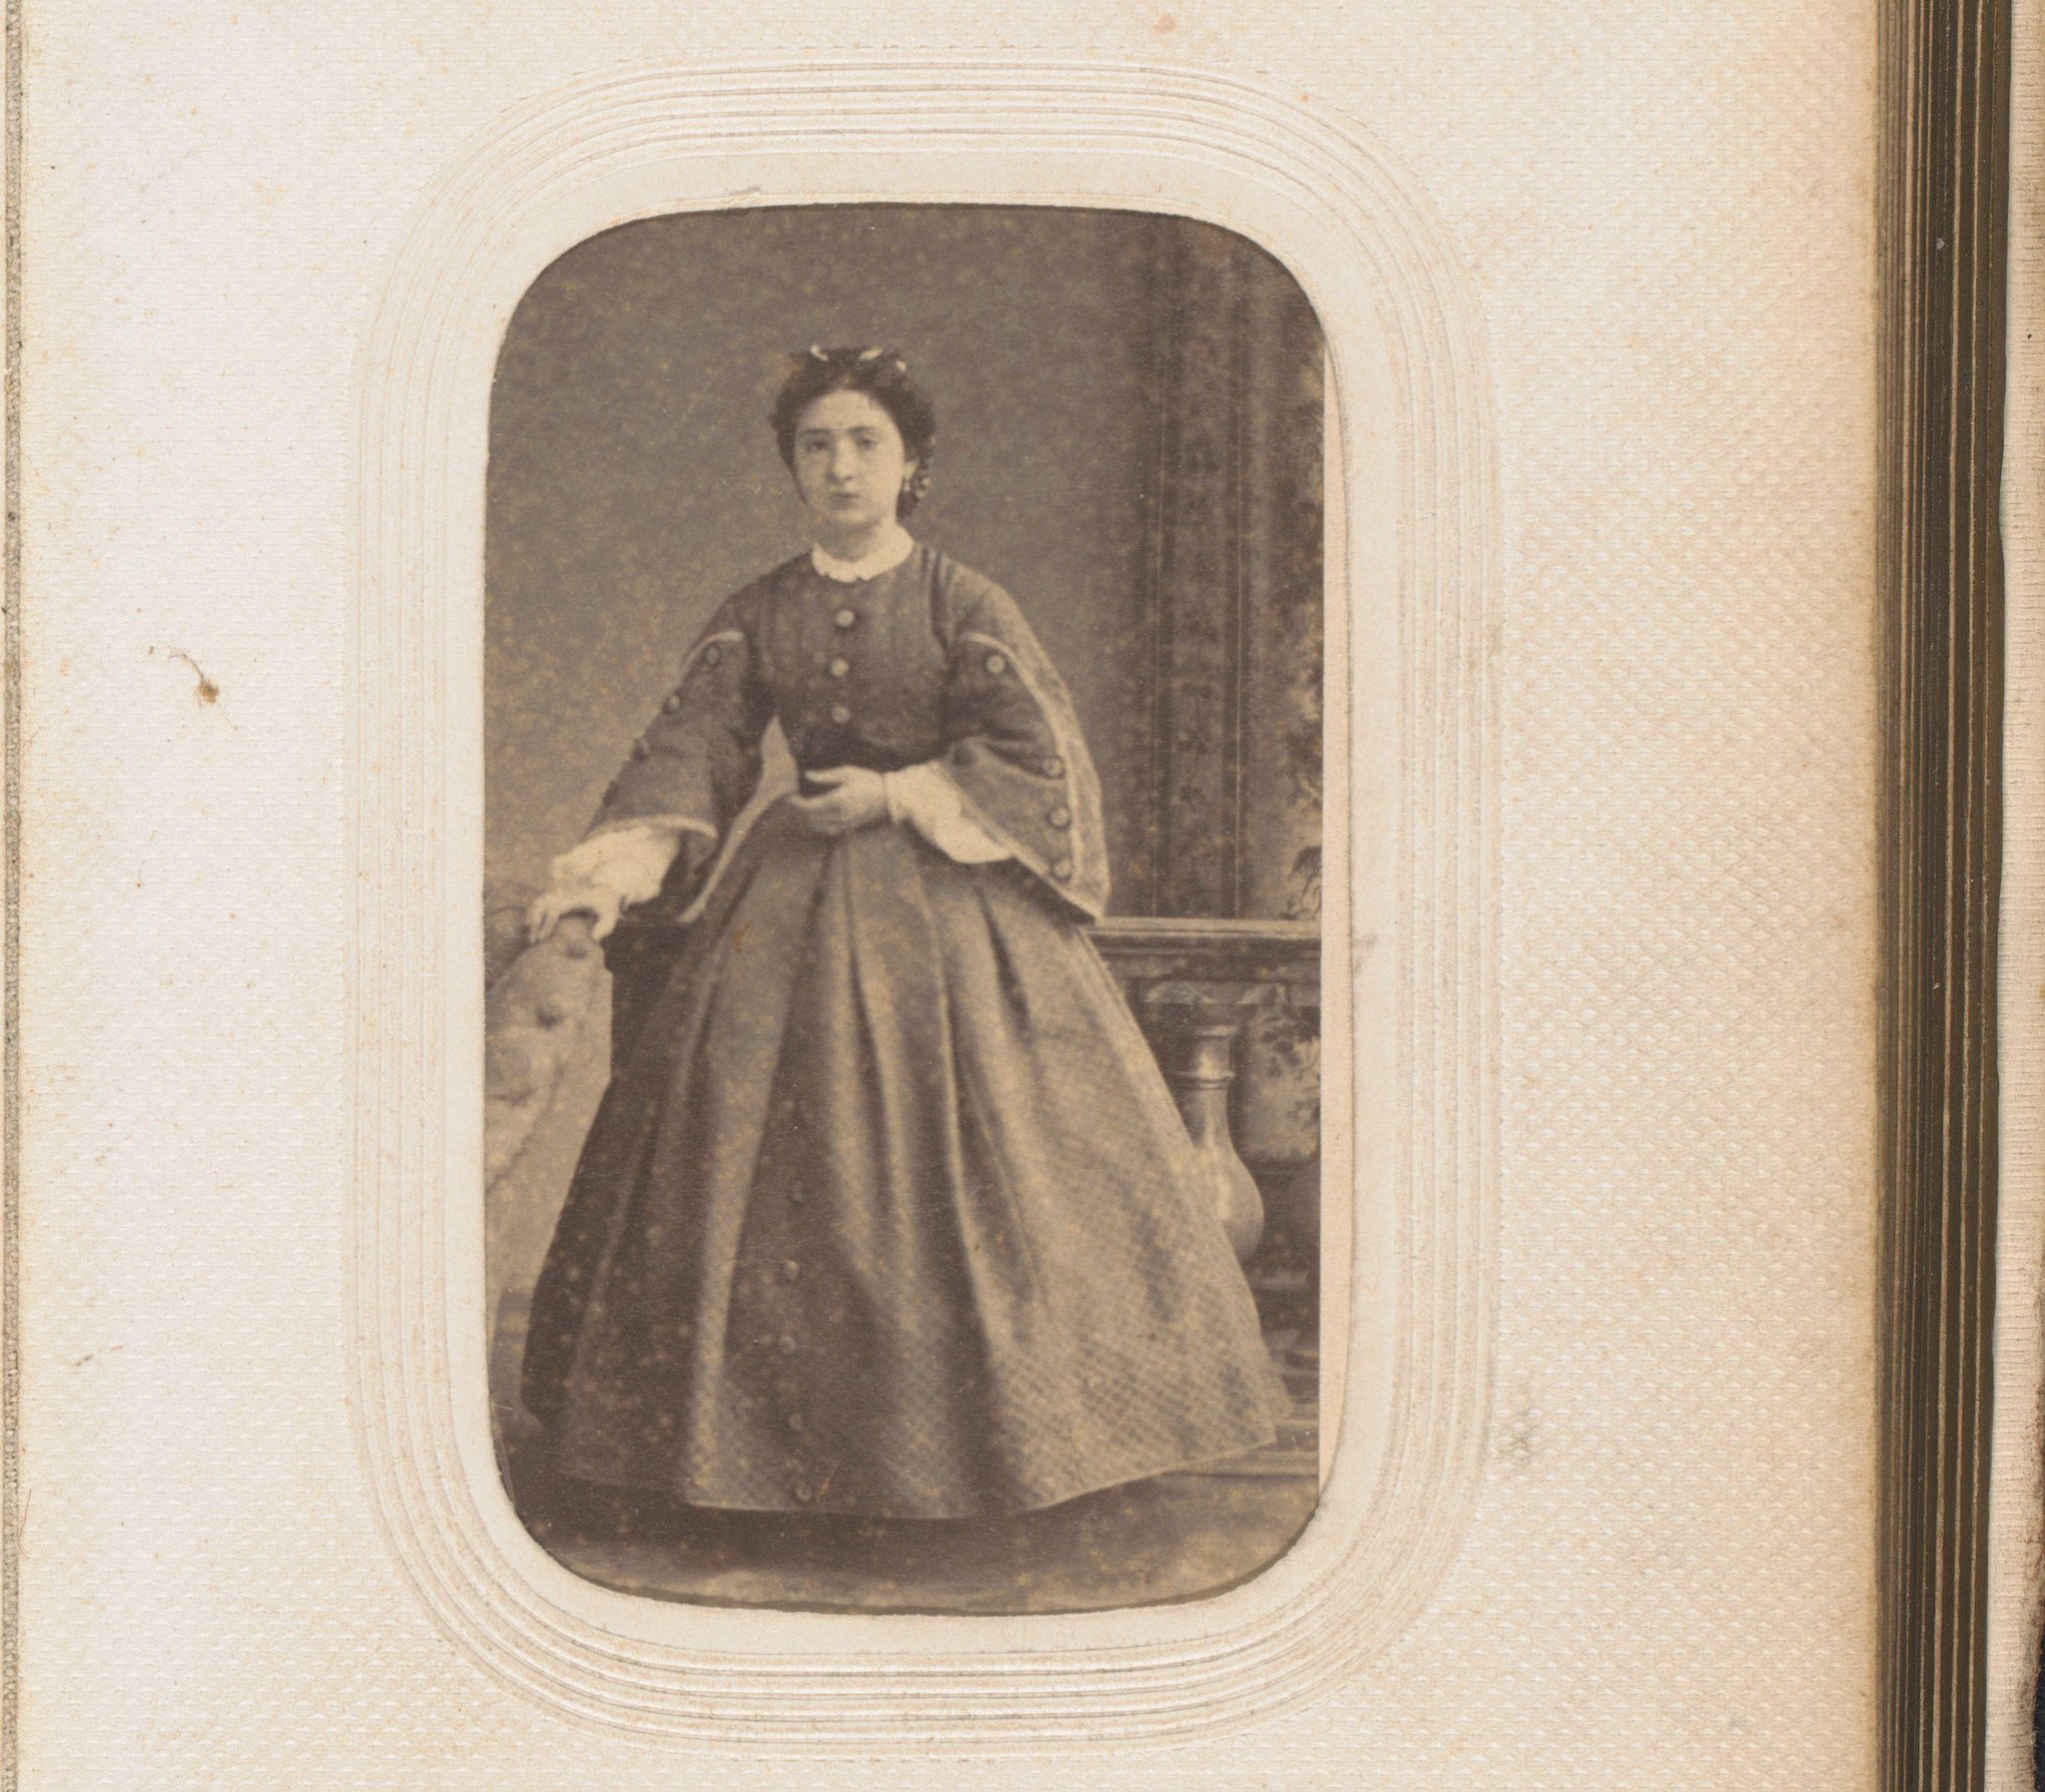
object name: carte de visite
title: Portret van een staande jonge vrouw bij een fauteuil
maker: jacques baylac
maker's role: fotograaf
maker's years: 1822-1906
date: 1855-1865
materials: cardboard, photographic support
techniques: albumen print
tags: adolescent, young woman, maiden, historical persons, chair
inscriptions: inscription: ‘behoeft restauratie Allees de Tourny 52, Bordeaux’